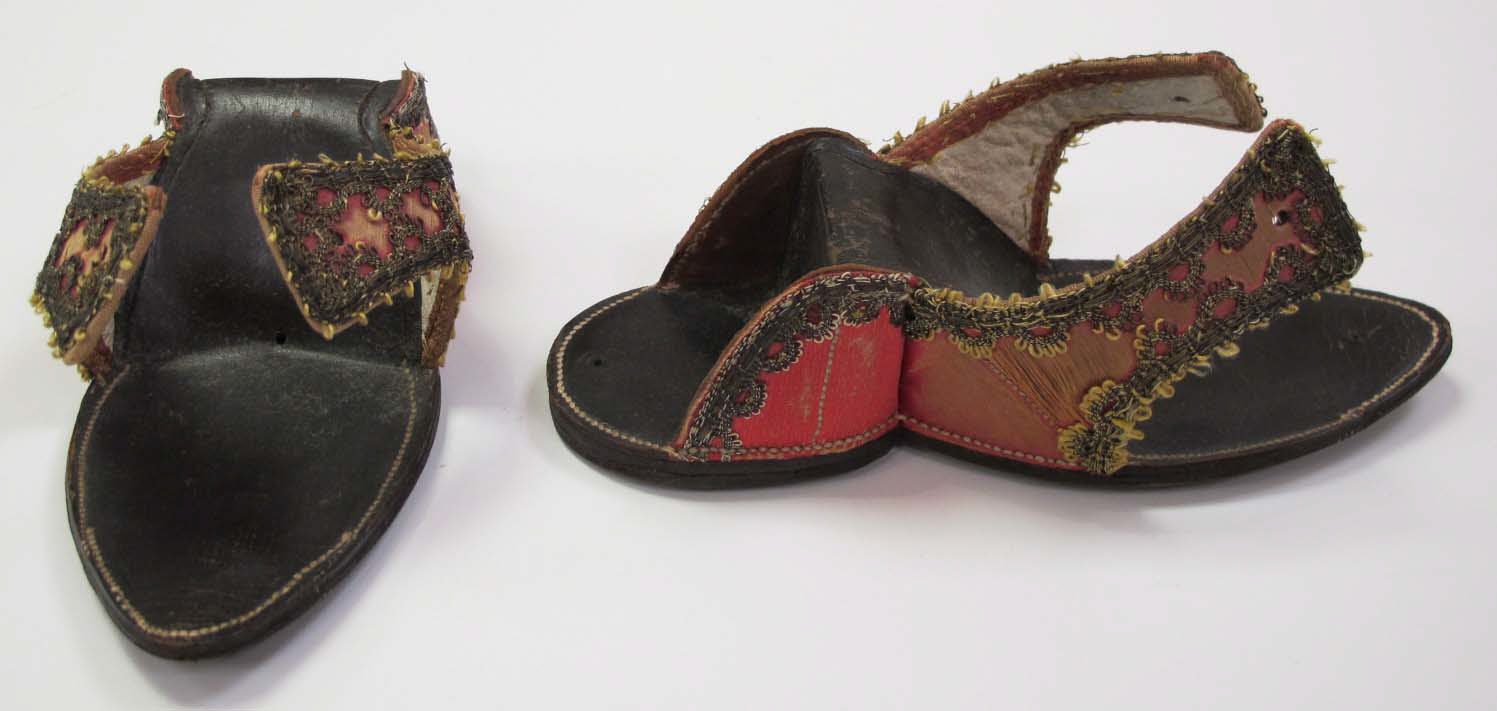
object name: patten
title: Pattens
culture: european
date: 1701-1733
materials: leather, silk